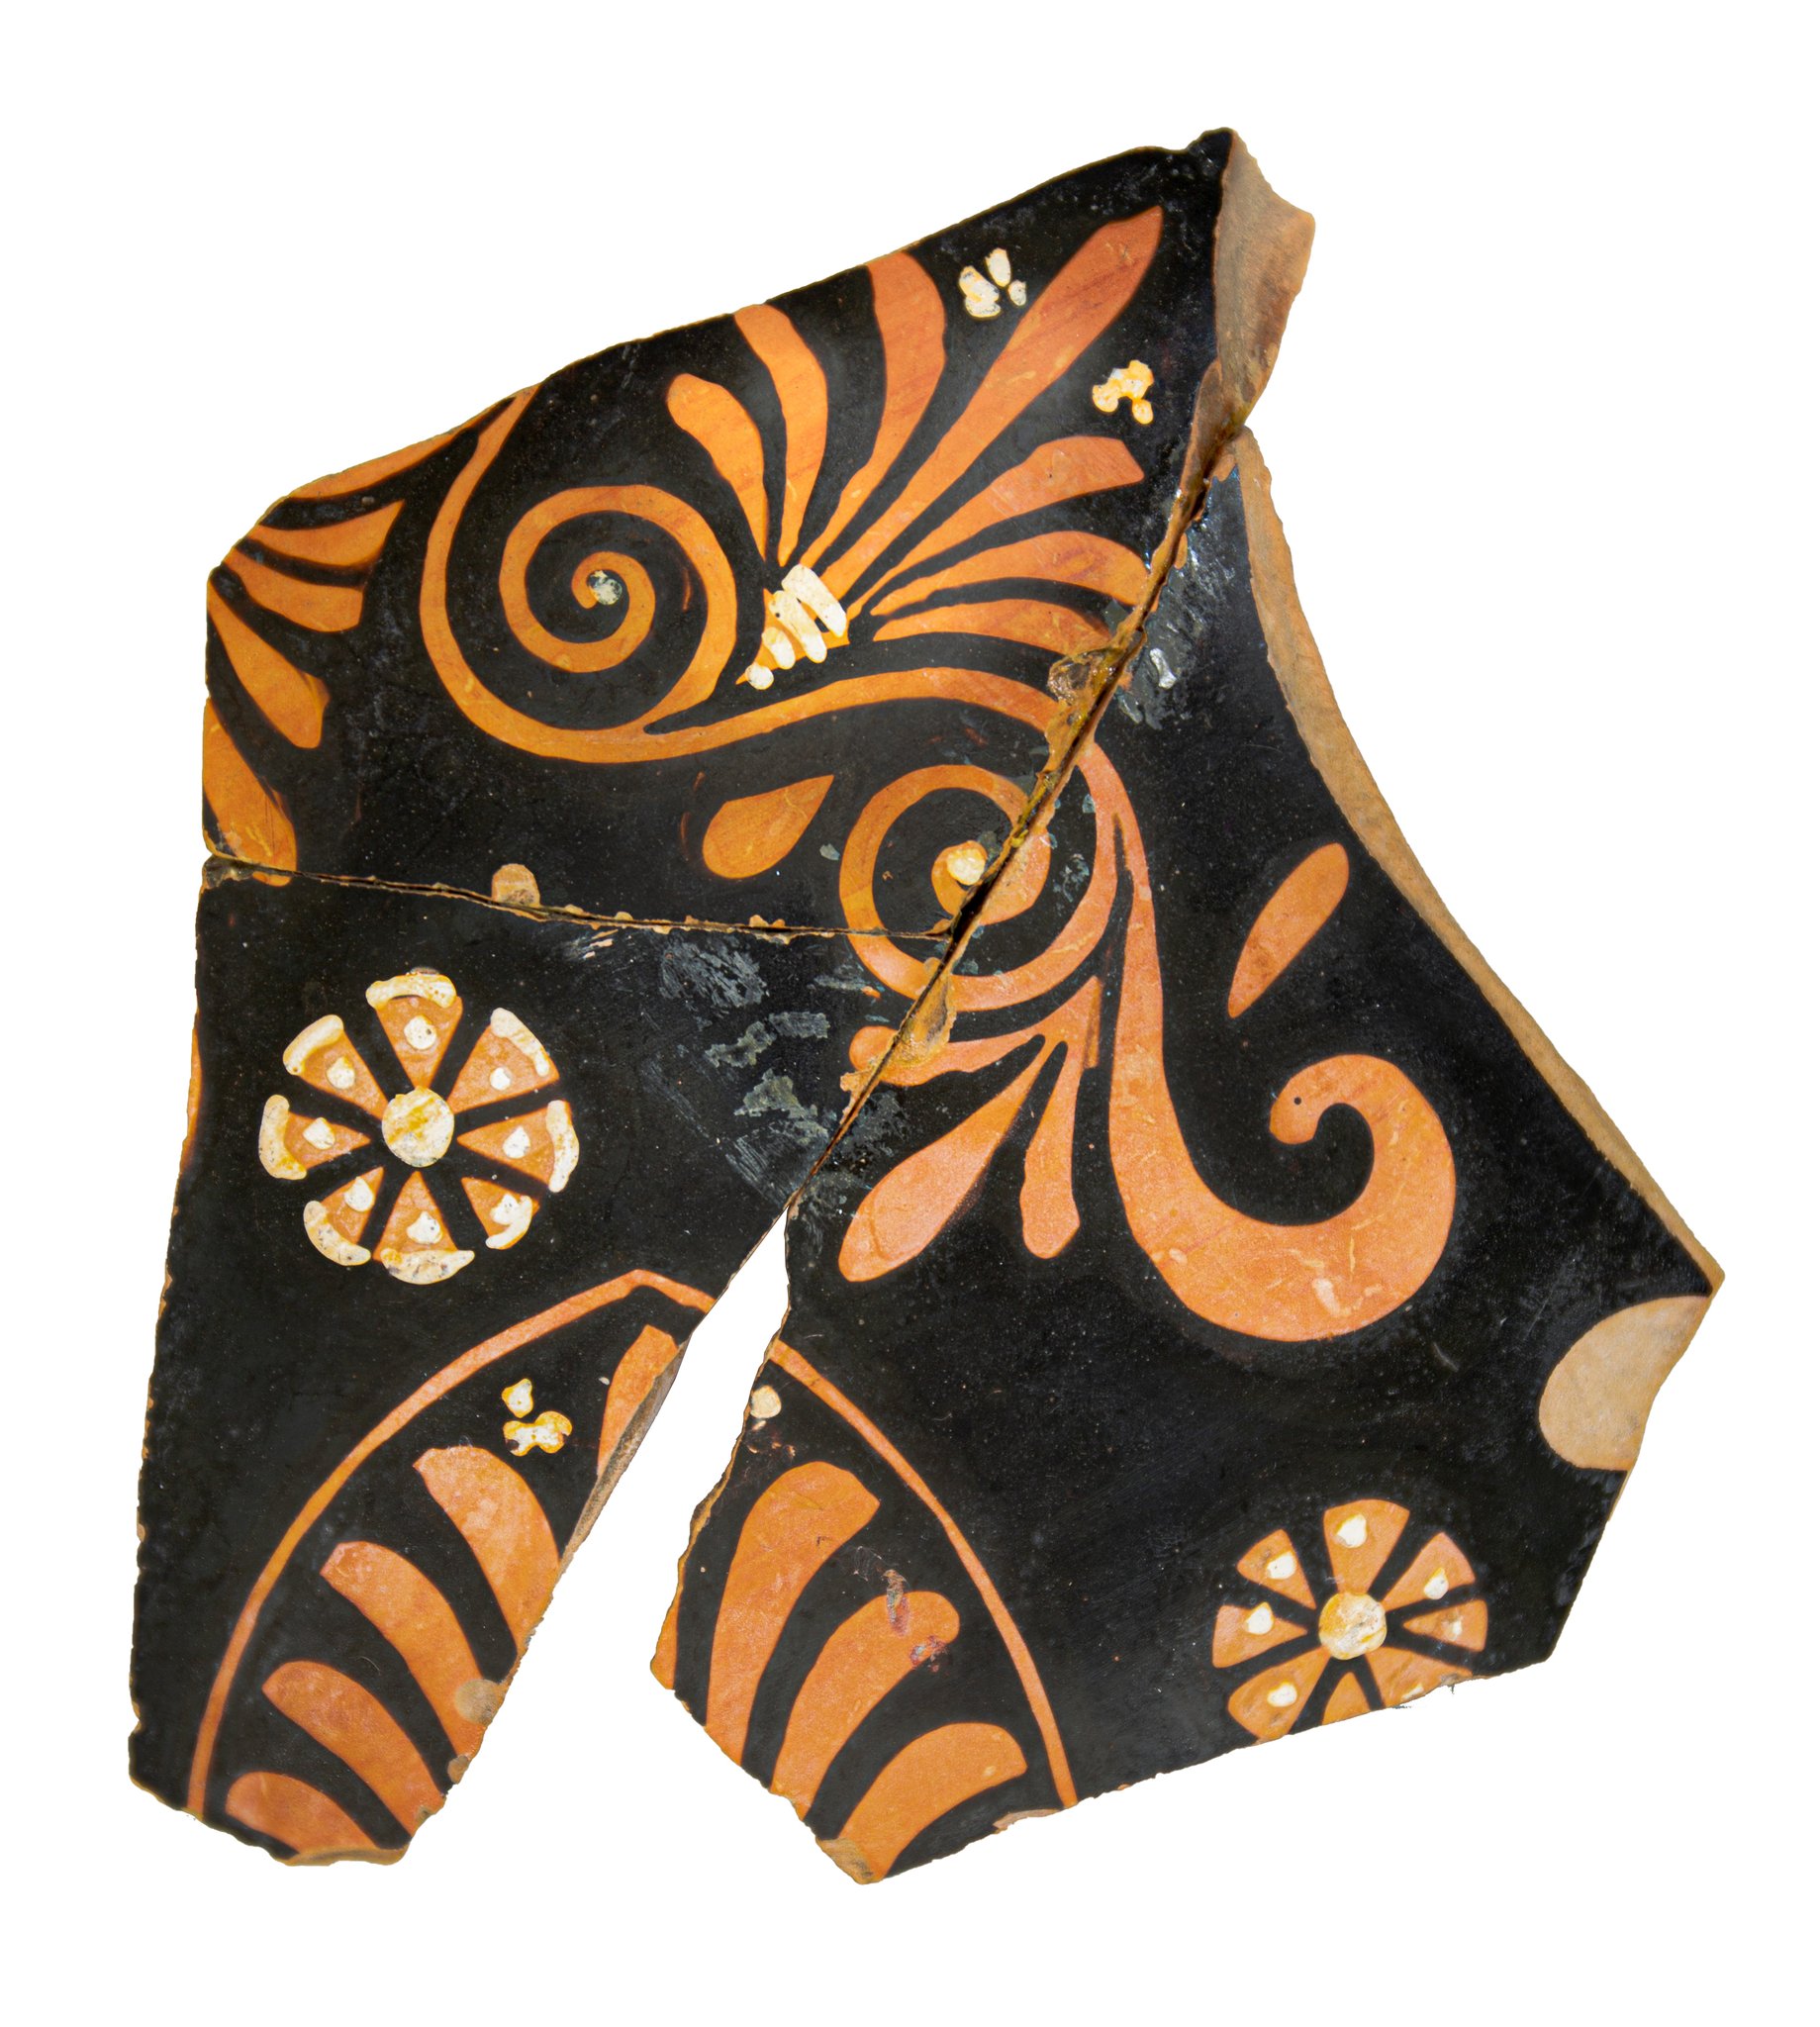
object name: volute krater fragment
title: Volute-krater fragment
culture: greek, south italian, apulian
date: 360-340 BCE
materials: terracotta